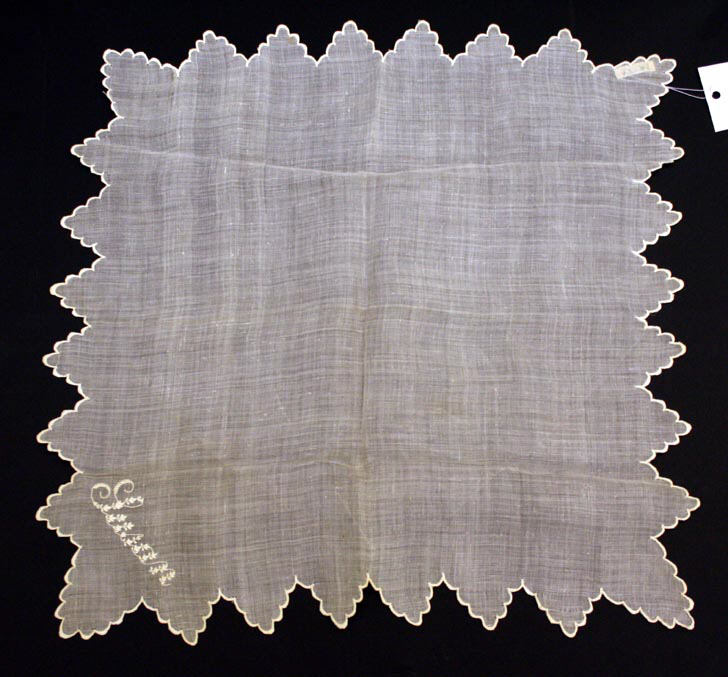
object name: handkerchief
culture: american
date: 1840-1850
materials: linen